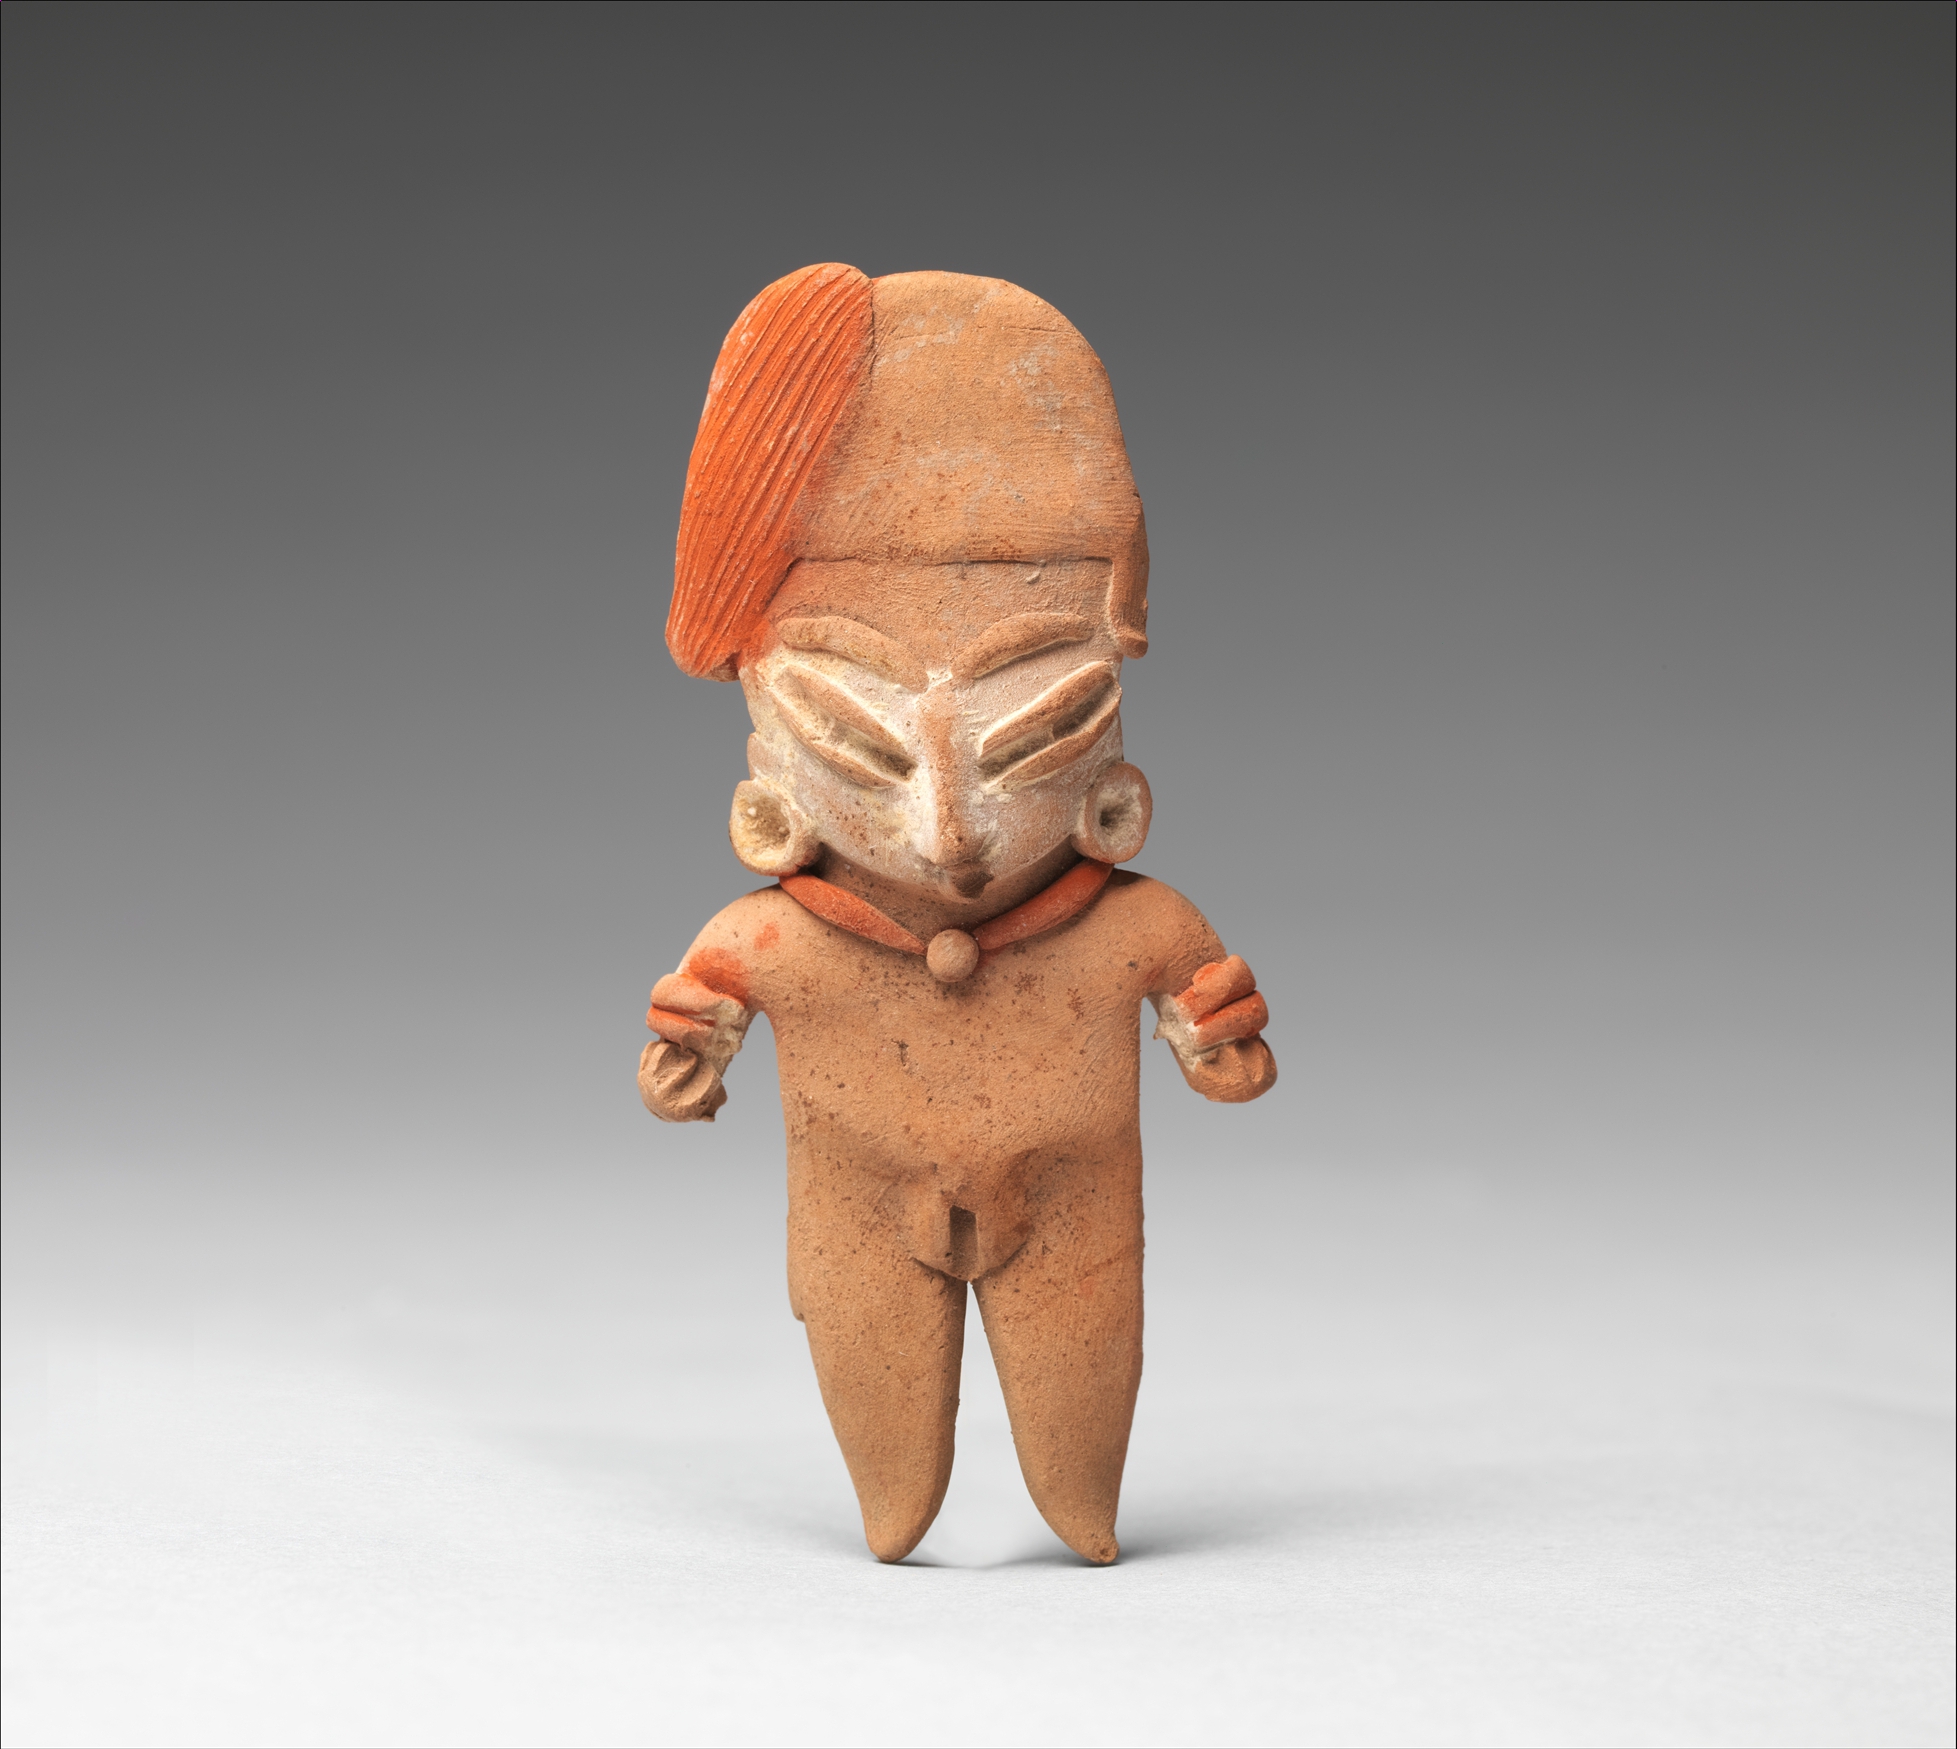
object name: female figure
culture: chupicuaro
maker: chupícuaro artist(s)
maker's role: artist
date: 400-100 BCE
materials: ceramic, pigment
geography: mexico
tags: female nudes